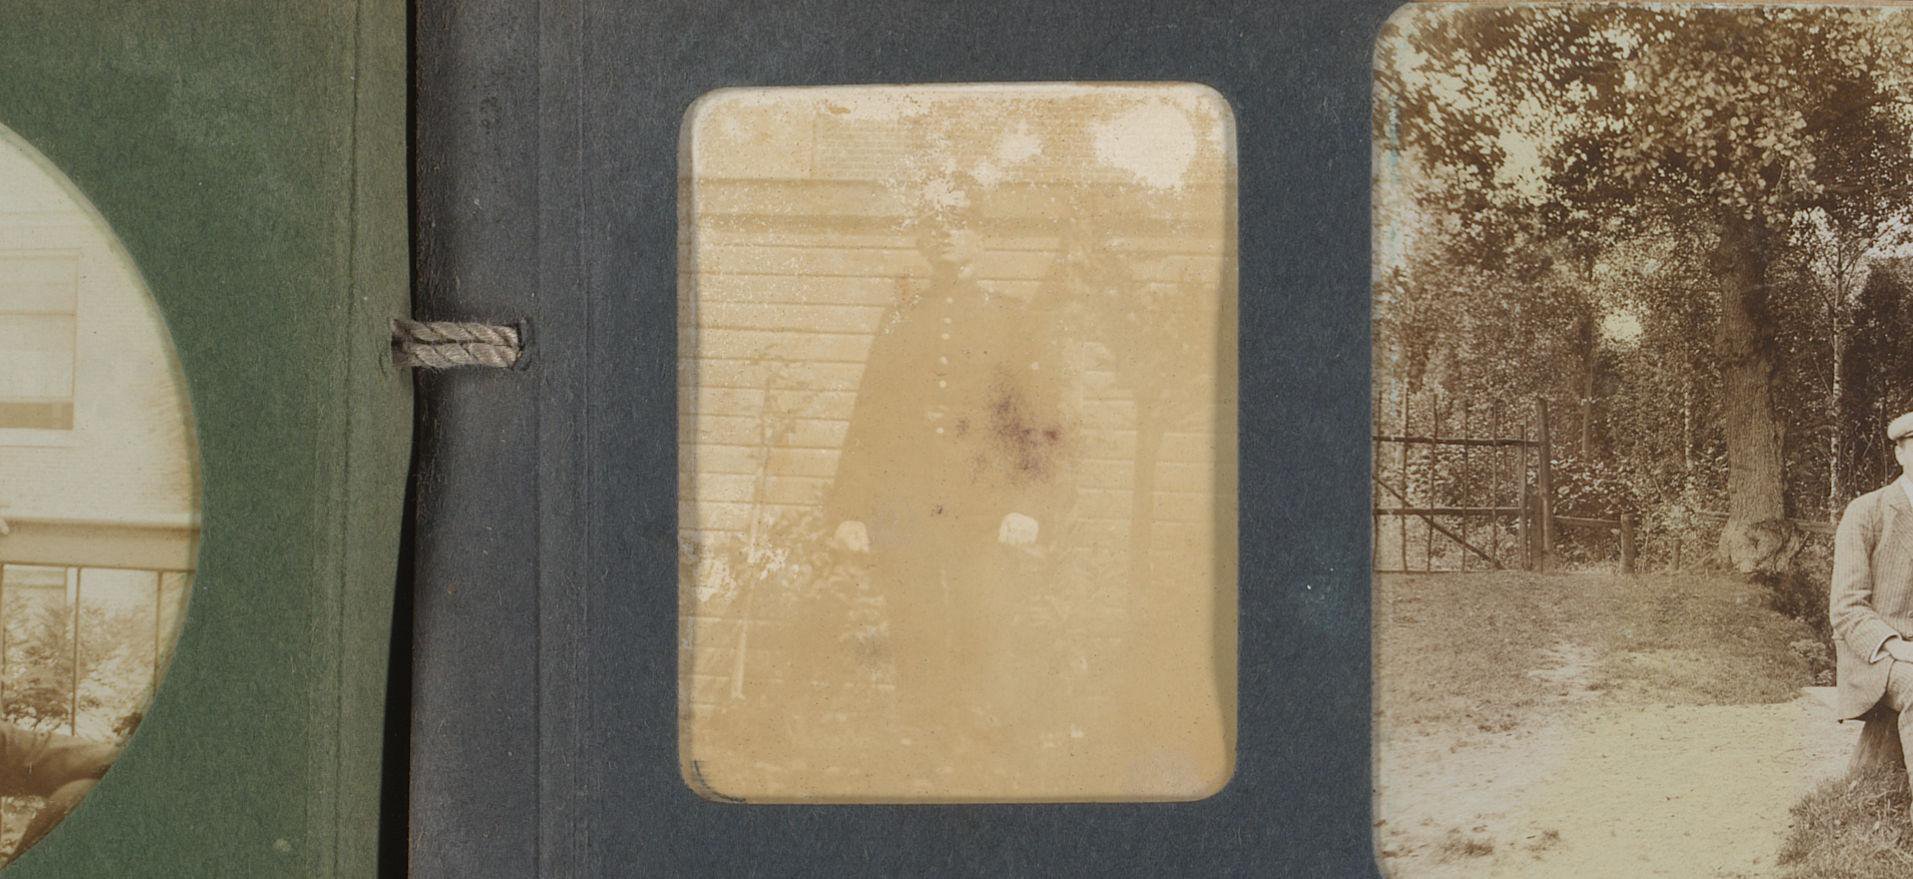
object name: album leaf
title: Portret van Jan van den Bussche in militair uniform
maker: Anonymous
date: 1910-1912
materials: paper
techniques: gelatin silver print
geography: gelderland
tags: historical persons, youth, adolescent, (military) uniforms, gelderland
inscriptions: inscription: ‘Jan v/d Bussche.’